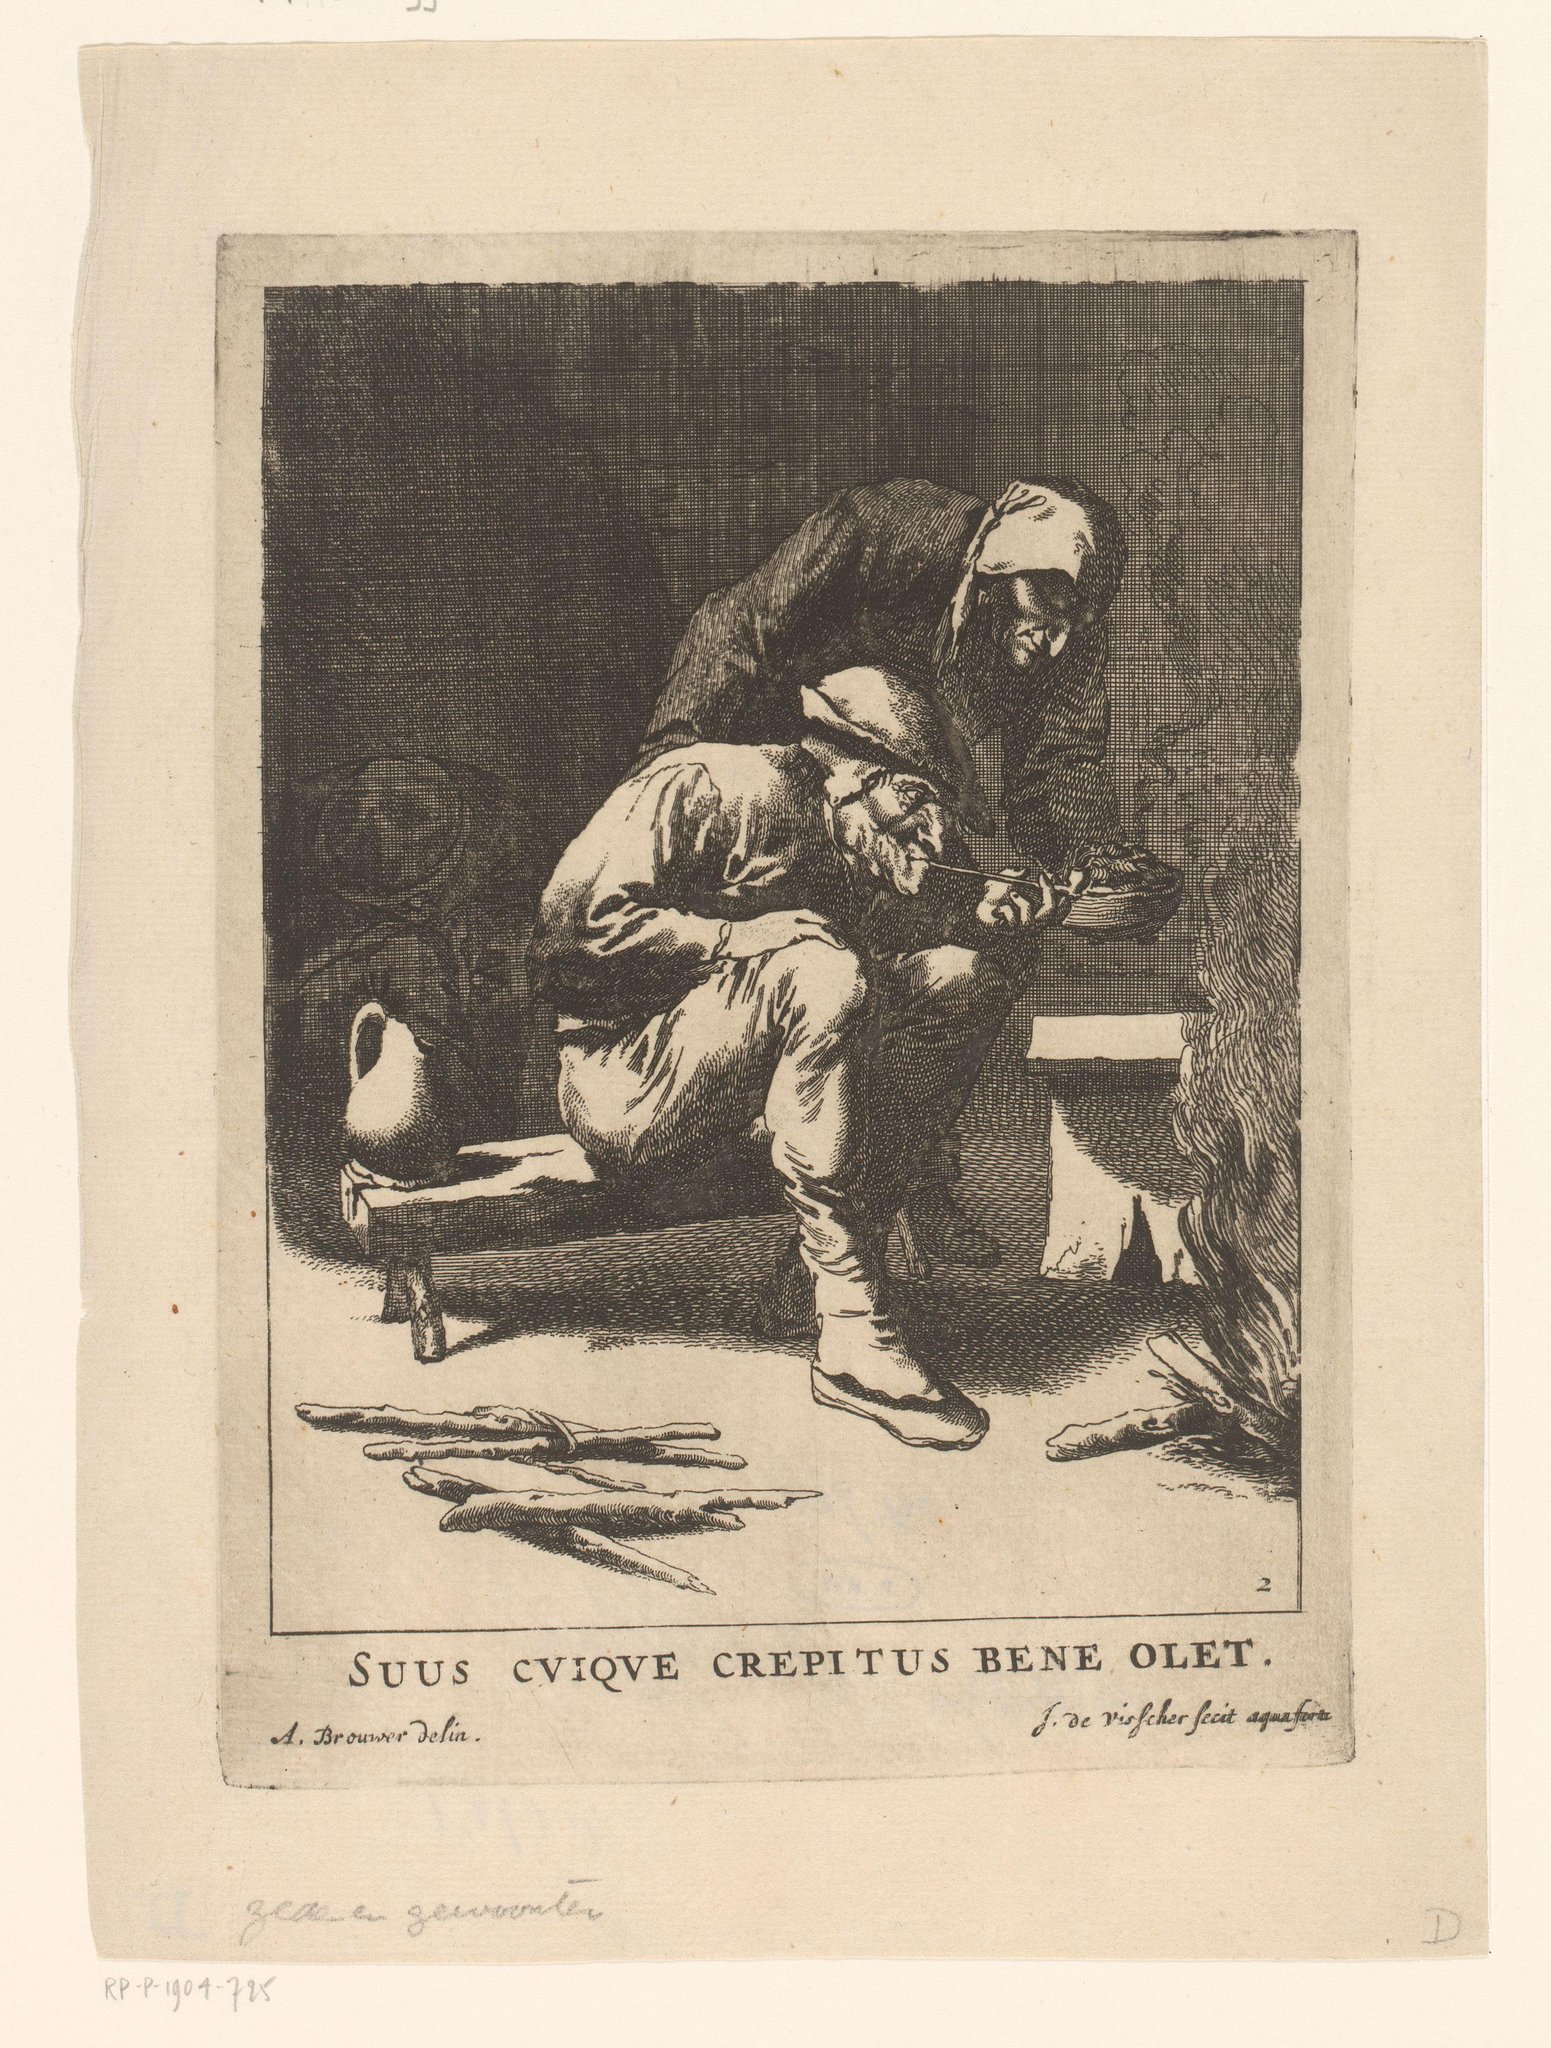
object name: print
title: Suus cuique crepitus bene olet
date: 1643-1677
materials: paper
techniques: etching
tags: pipe ~ tobacco, open hearth, fire-place, farmers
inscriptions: collector's mark: Lugt 2228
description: Pijprokende man, zittend op een lage houten bank bij een haardvuur. Achter hem een oude vrouw die hem een vuurtest voorhoudt. Rechtsonder genummerd: 2.